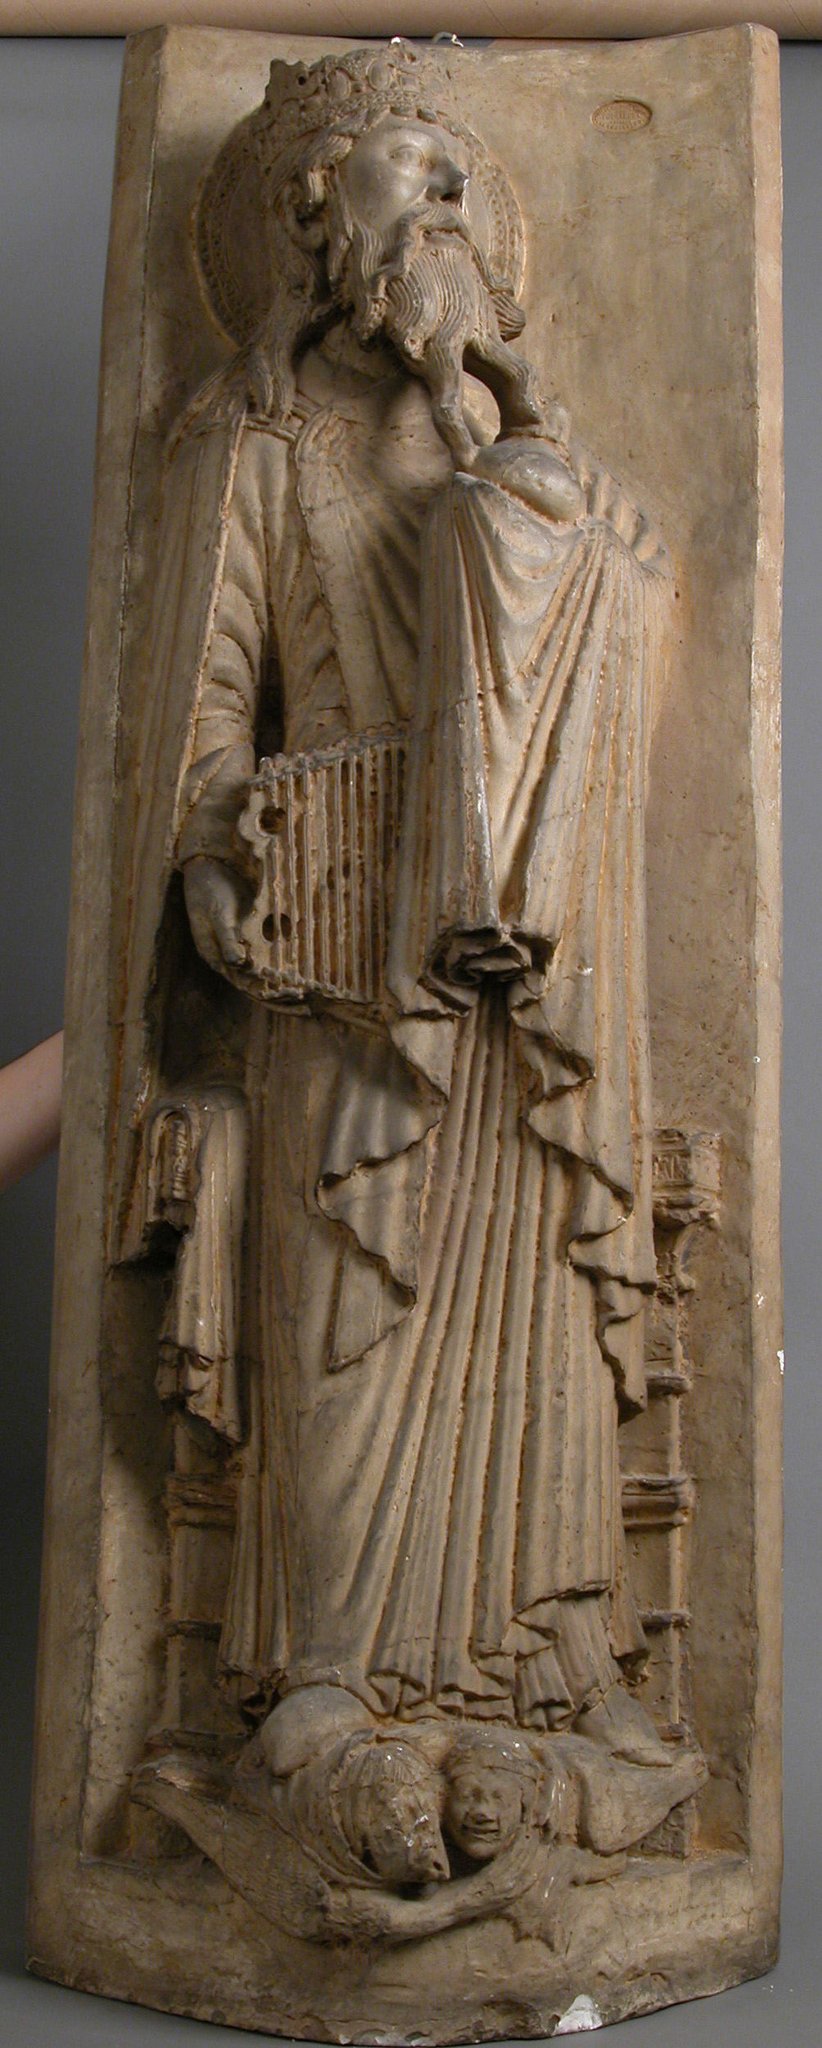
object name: elder of the apocalypse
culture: french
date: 1145-1155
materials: plaster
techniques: casting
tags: men,apocalypse